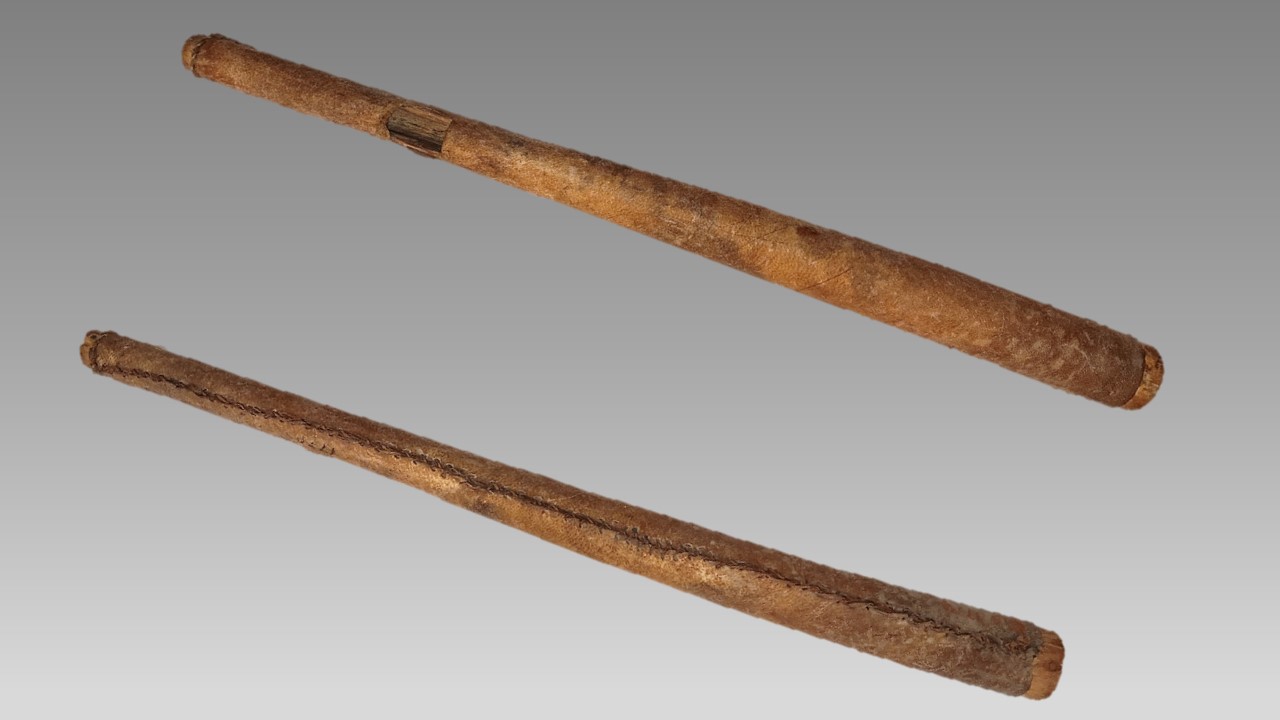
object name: horn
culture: african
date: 1867-1900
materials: skin, wood